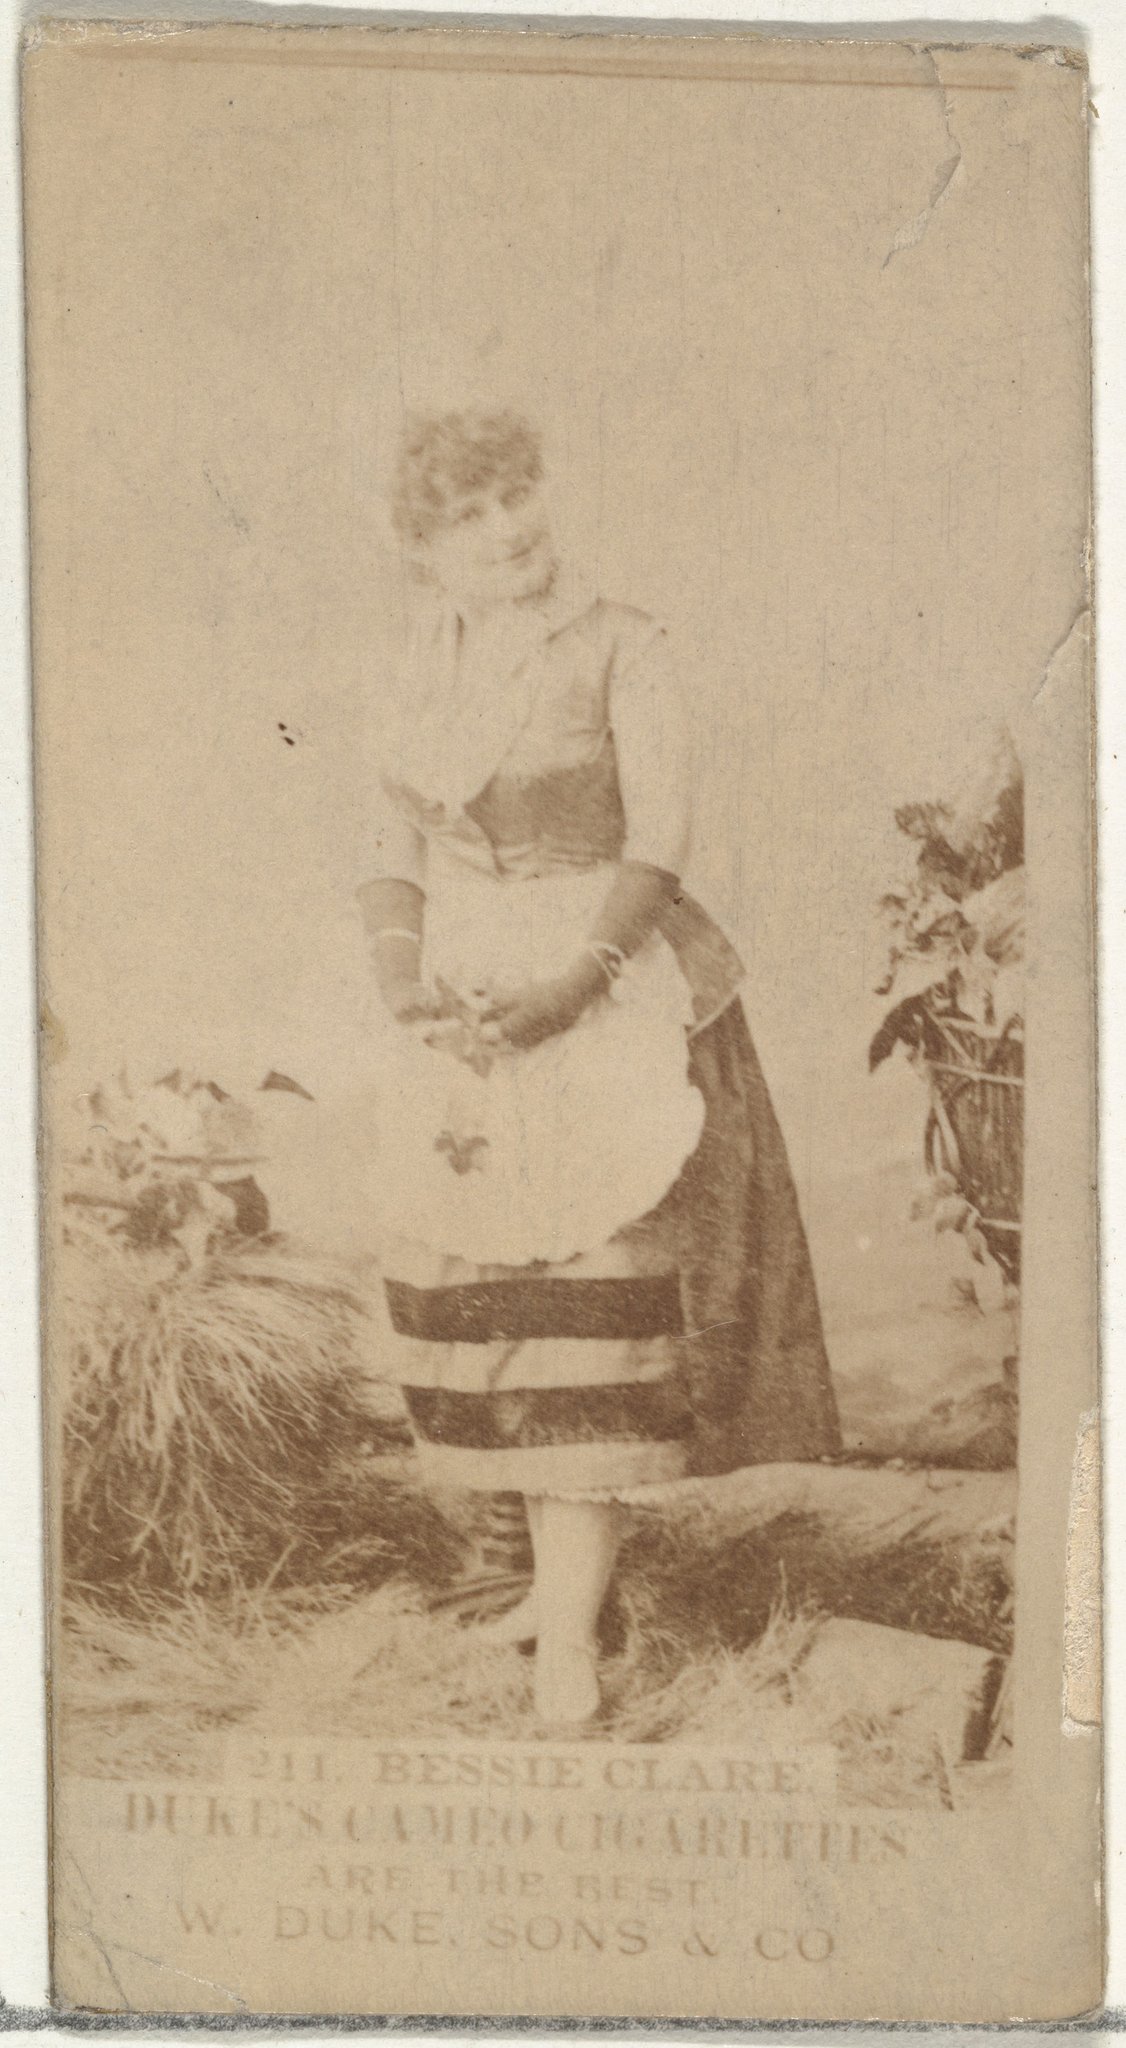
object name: photograph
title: Card Number 211, Bessie Clare, from the Actors and Actresses series (N145-5) issued by Duke Sons & Co. to promote Cameo Cigarettes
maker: w. duke, sons & co.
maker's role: publisher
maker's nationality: american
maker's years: 1870-1920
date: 1880-1889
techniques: albumen silver print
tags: portraits,women,actresses